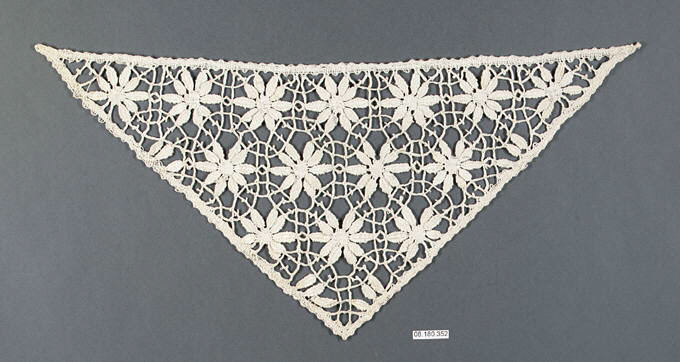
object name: piece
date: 1801-1900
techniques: lace